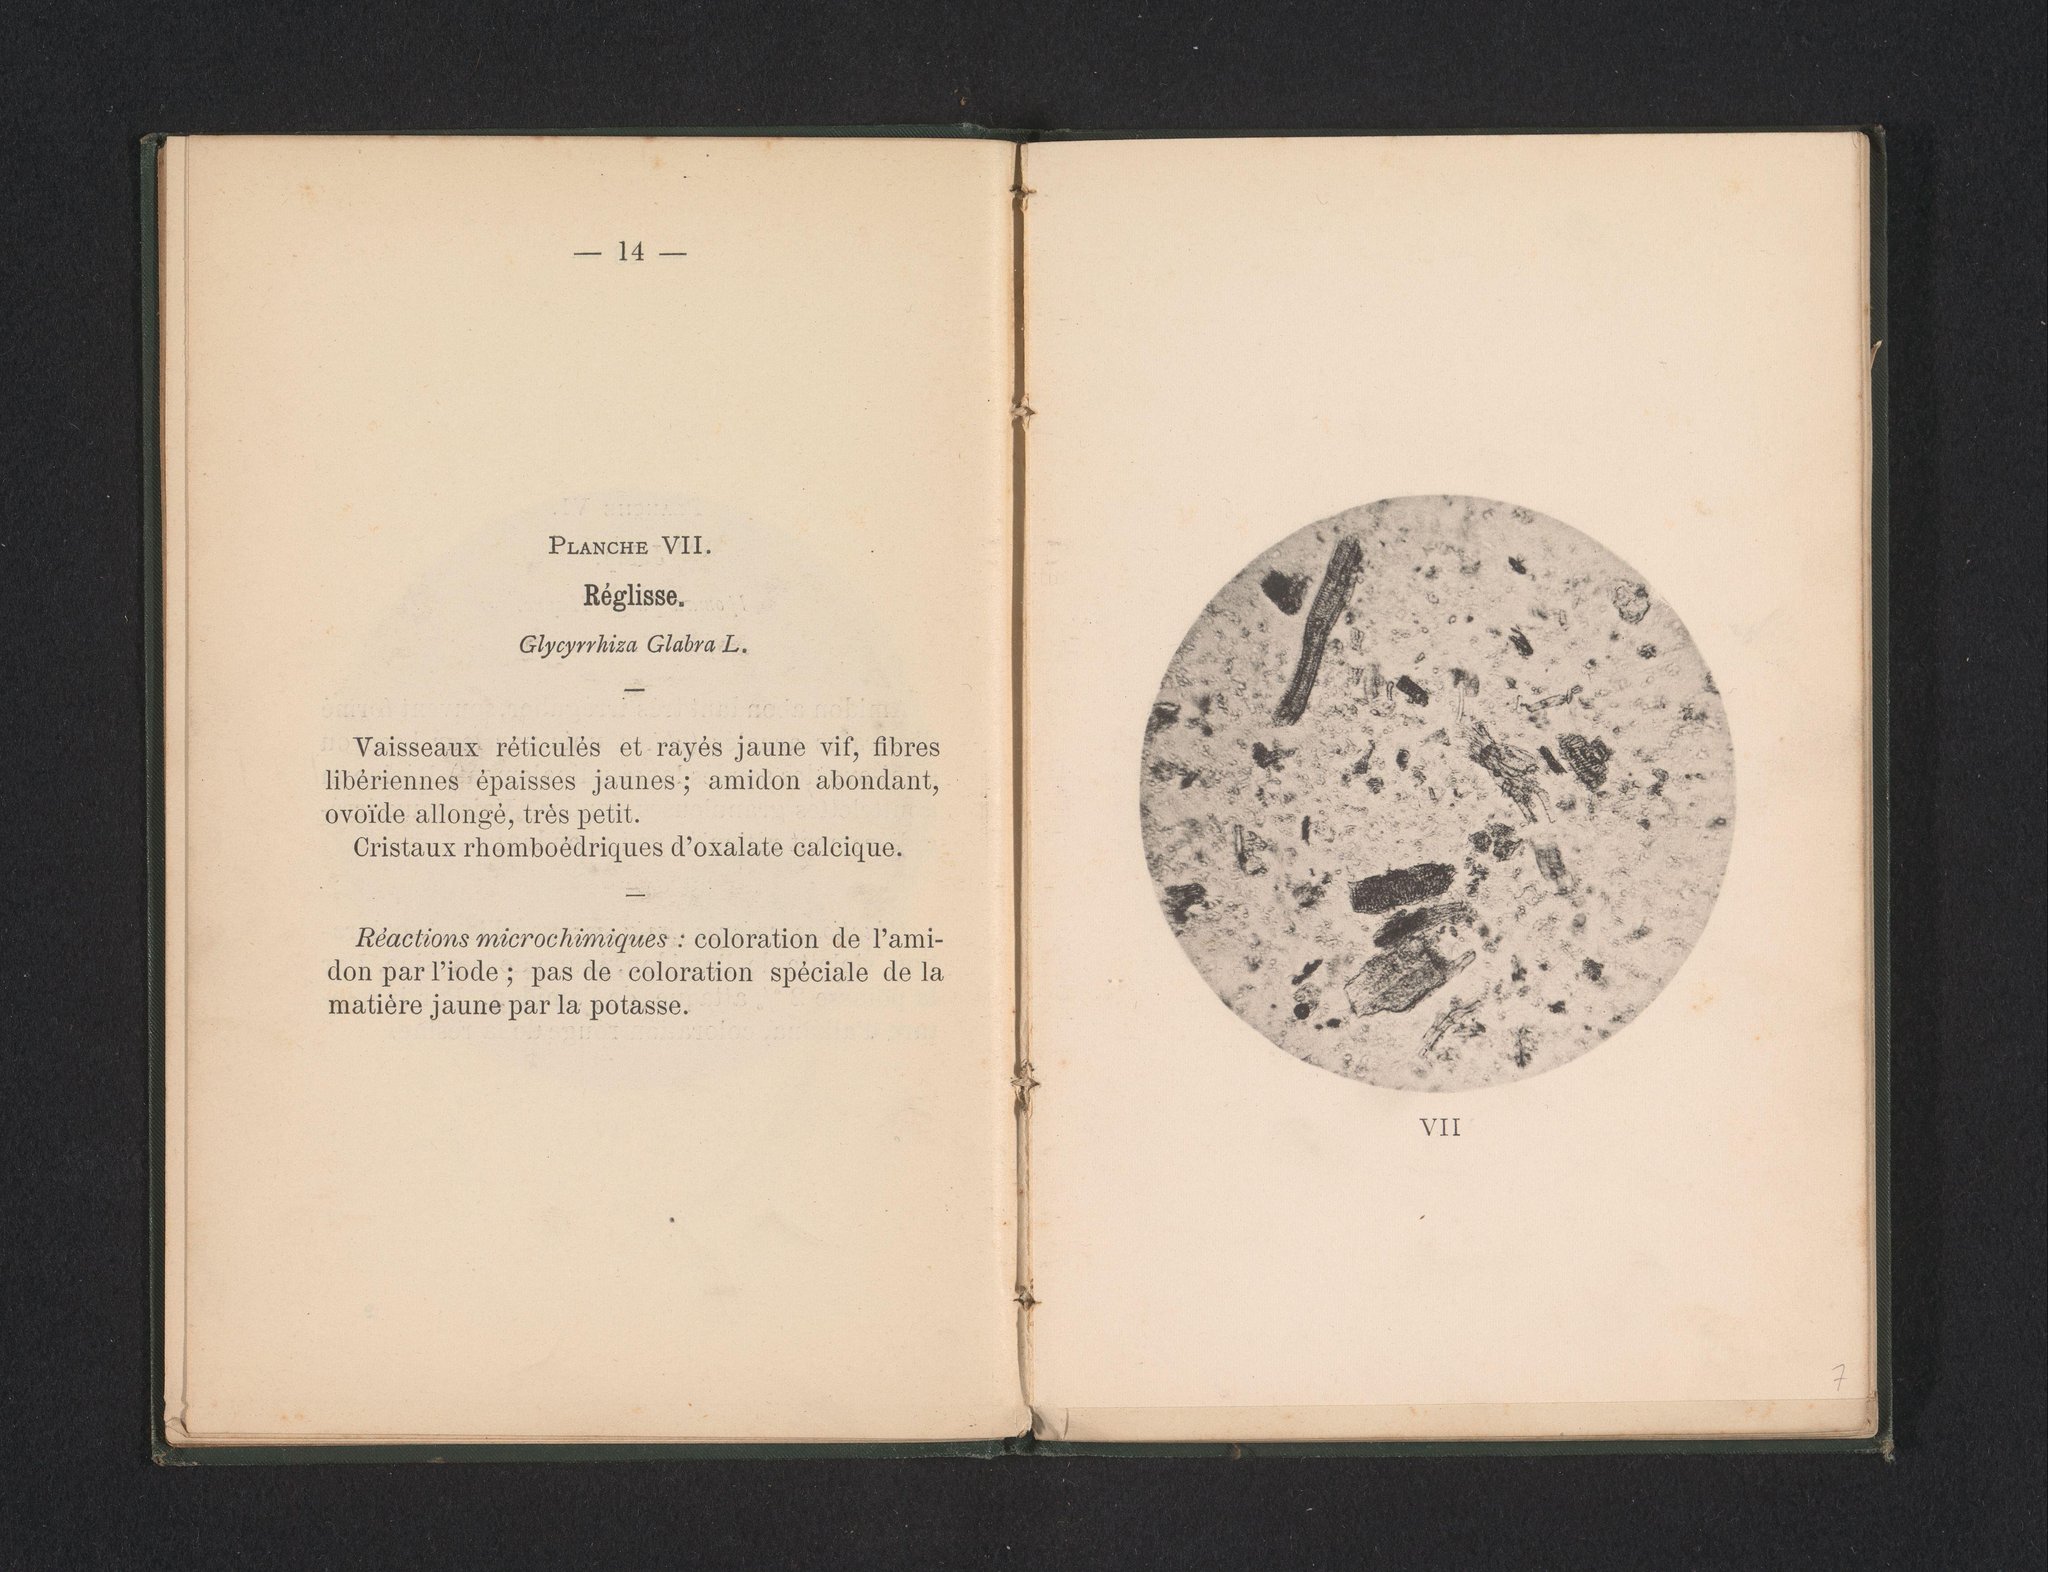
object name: photomechanical print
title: Microscopische weergave van zoethout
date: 1891-1896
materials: paper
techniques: photograph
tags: microscope (+ scientific research)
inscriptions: number: ‘VII’